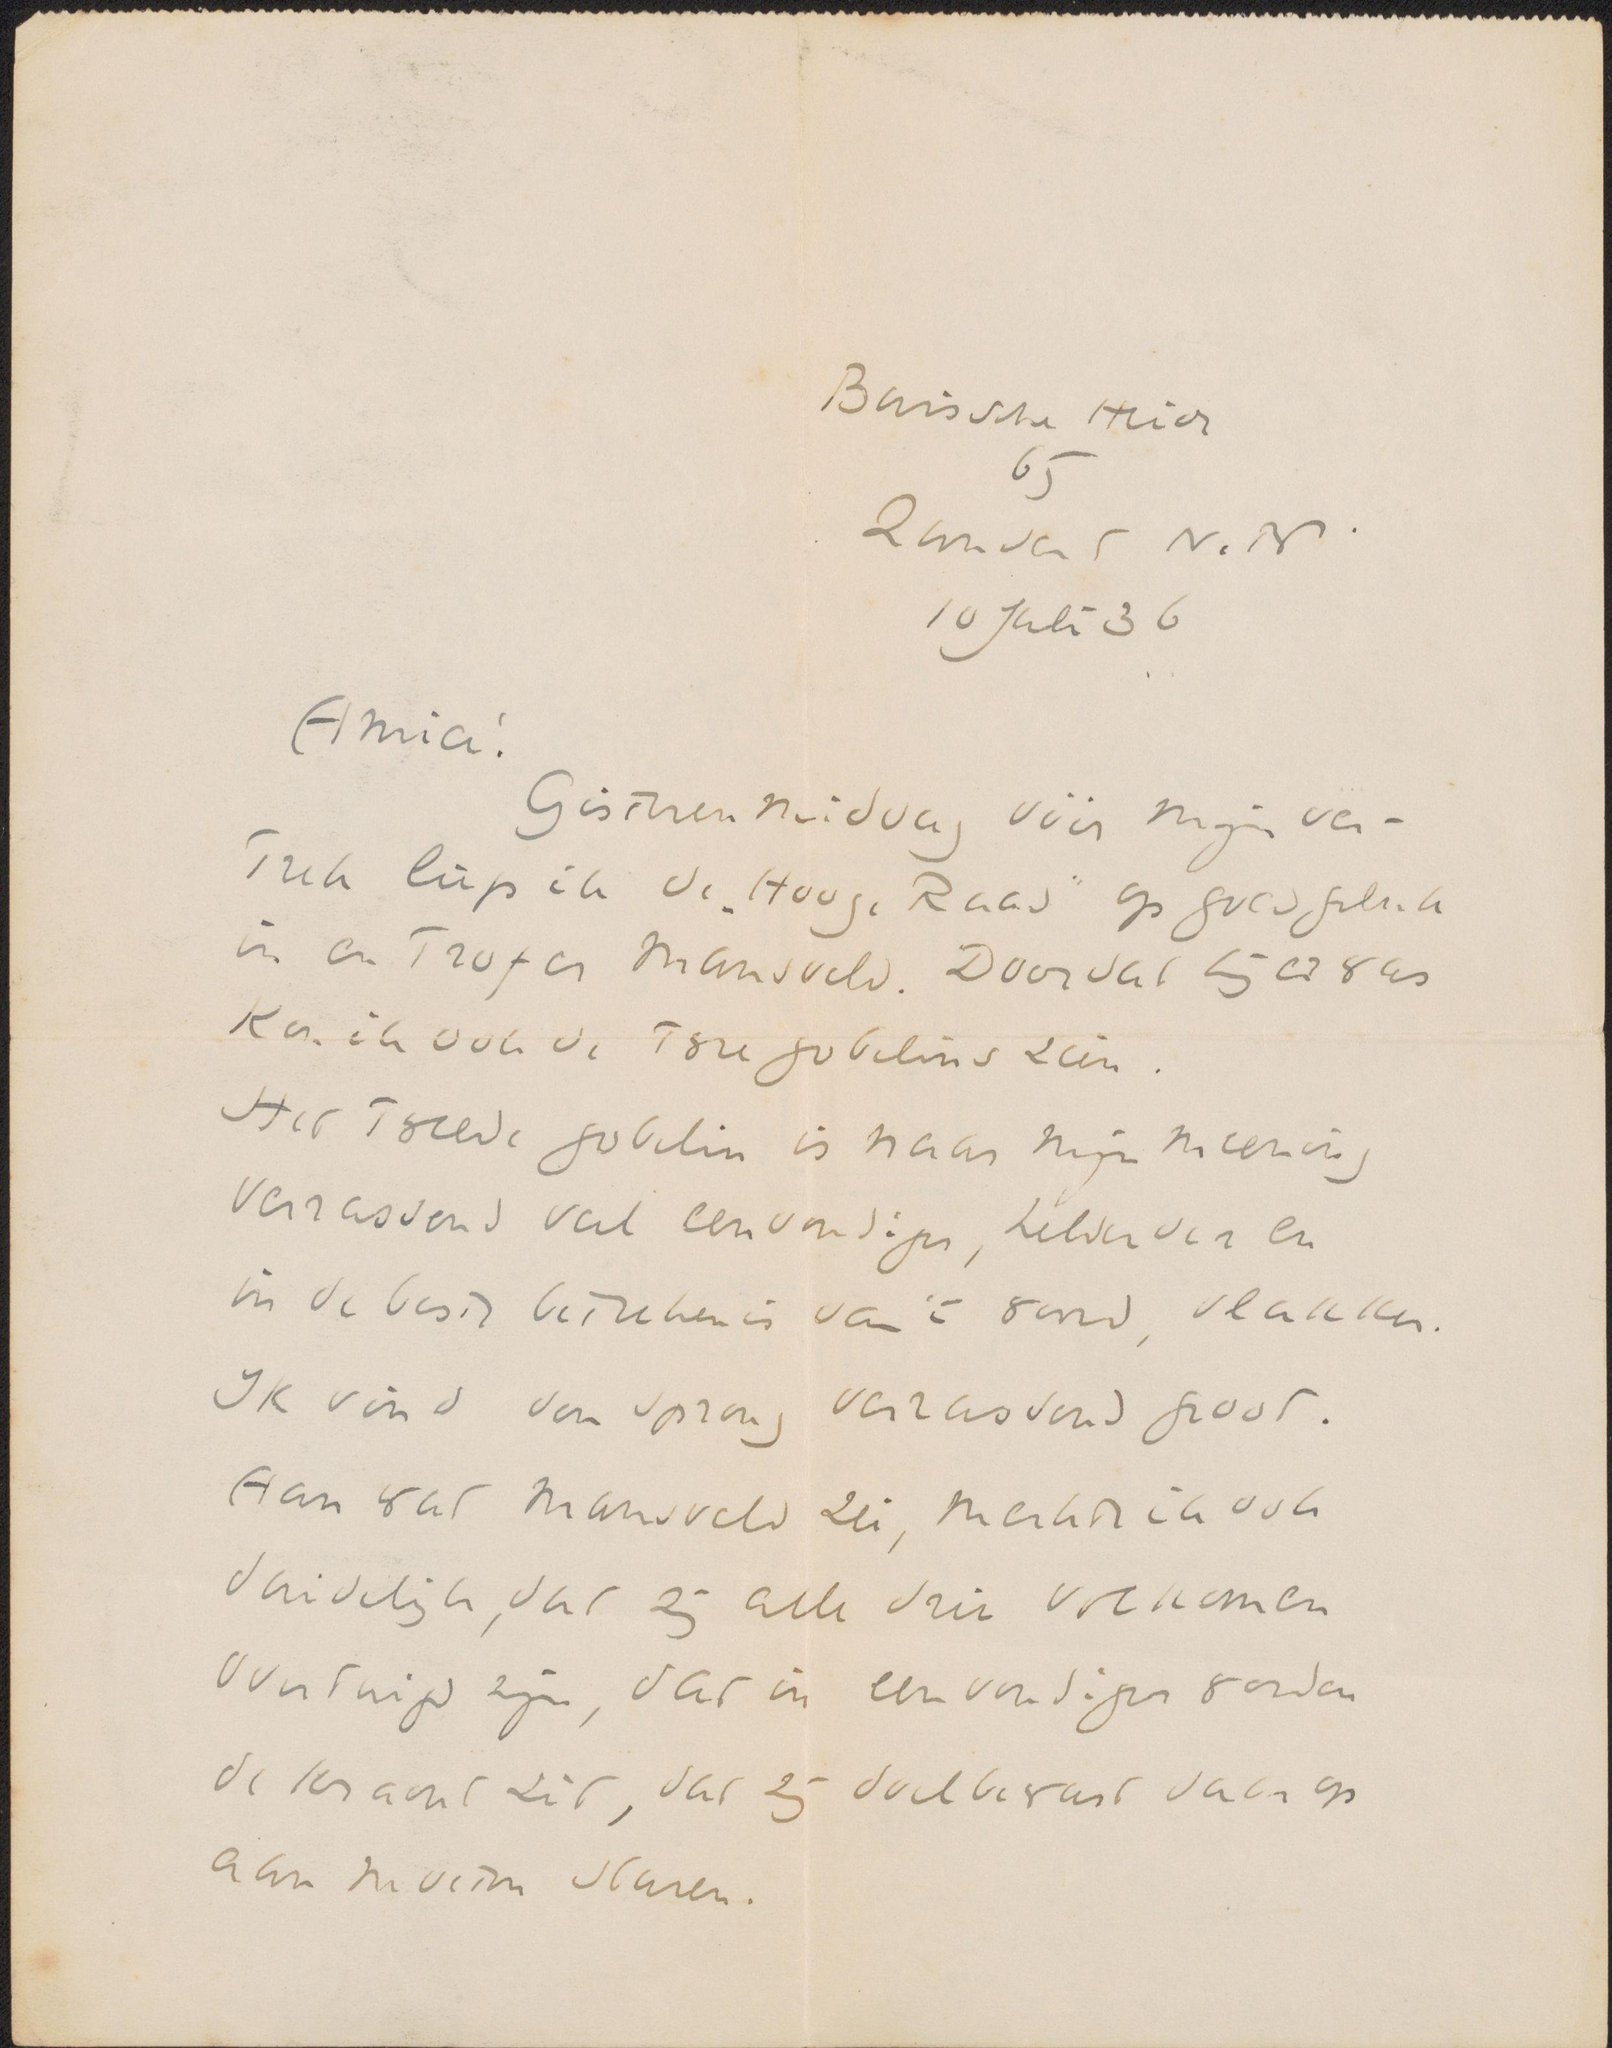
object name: letter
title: Brief aan Willem Frederik Gouwe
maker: richard nicolaüs roland holst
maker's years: 1868-1938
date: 1936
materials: ink, paper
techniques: pen, writing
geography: zundert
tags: applied arts, arts and crafts; industrial design